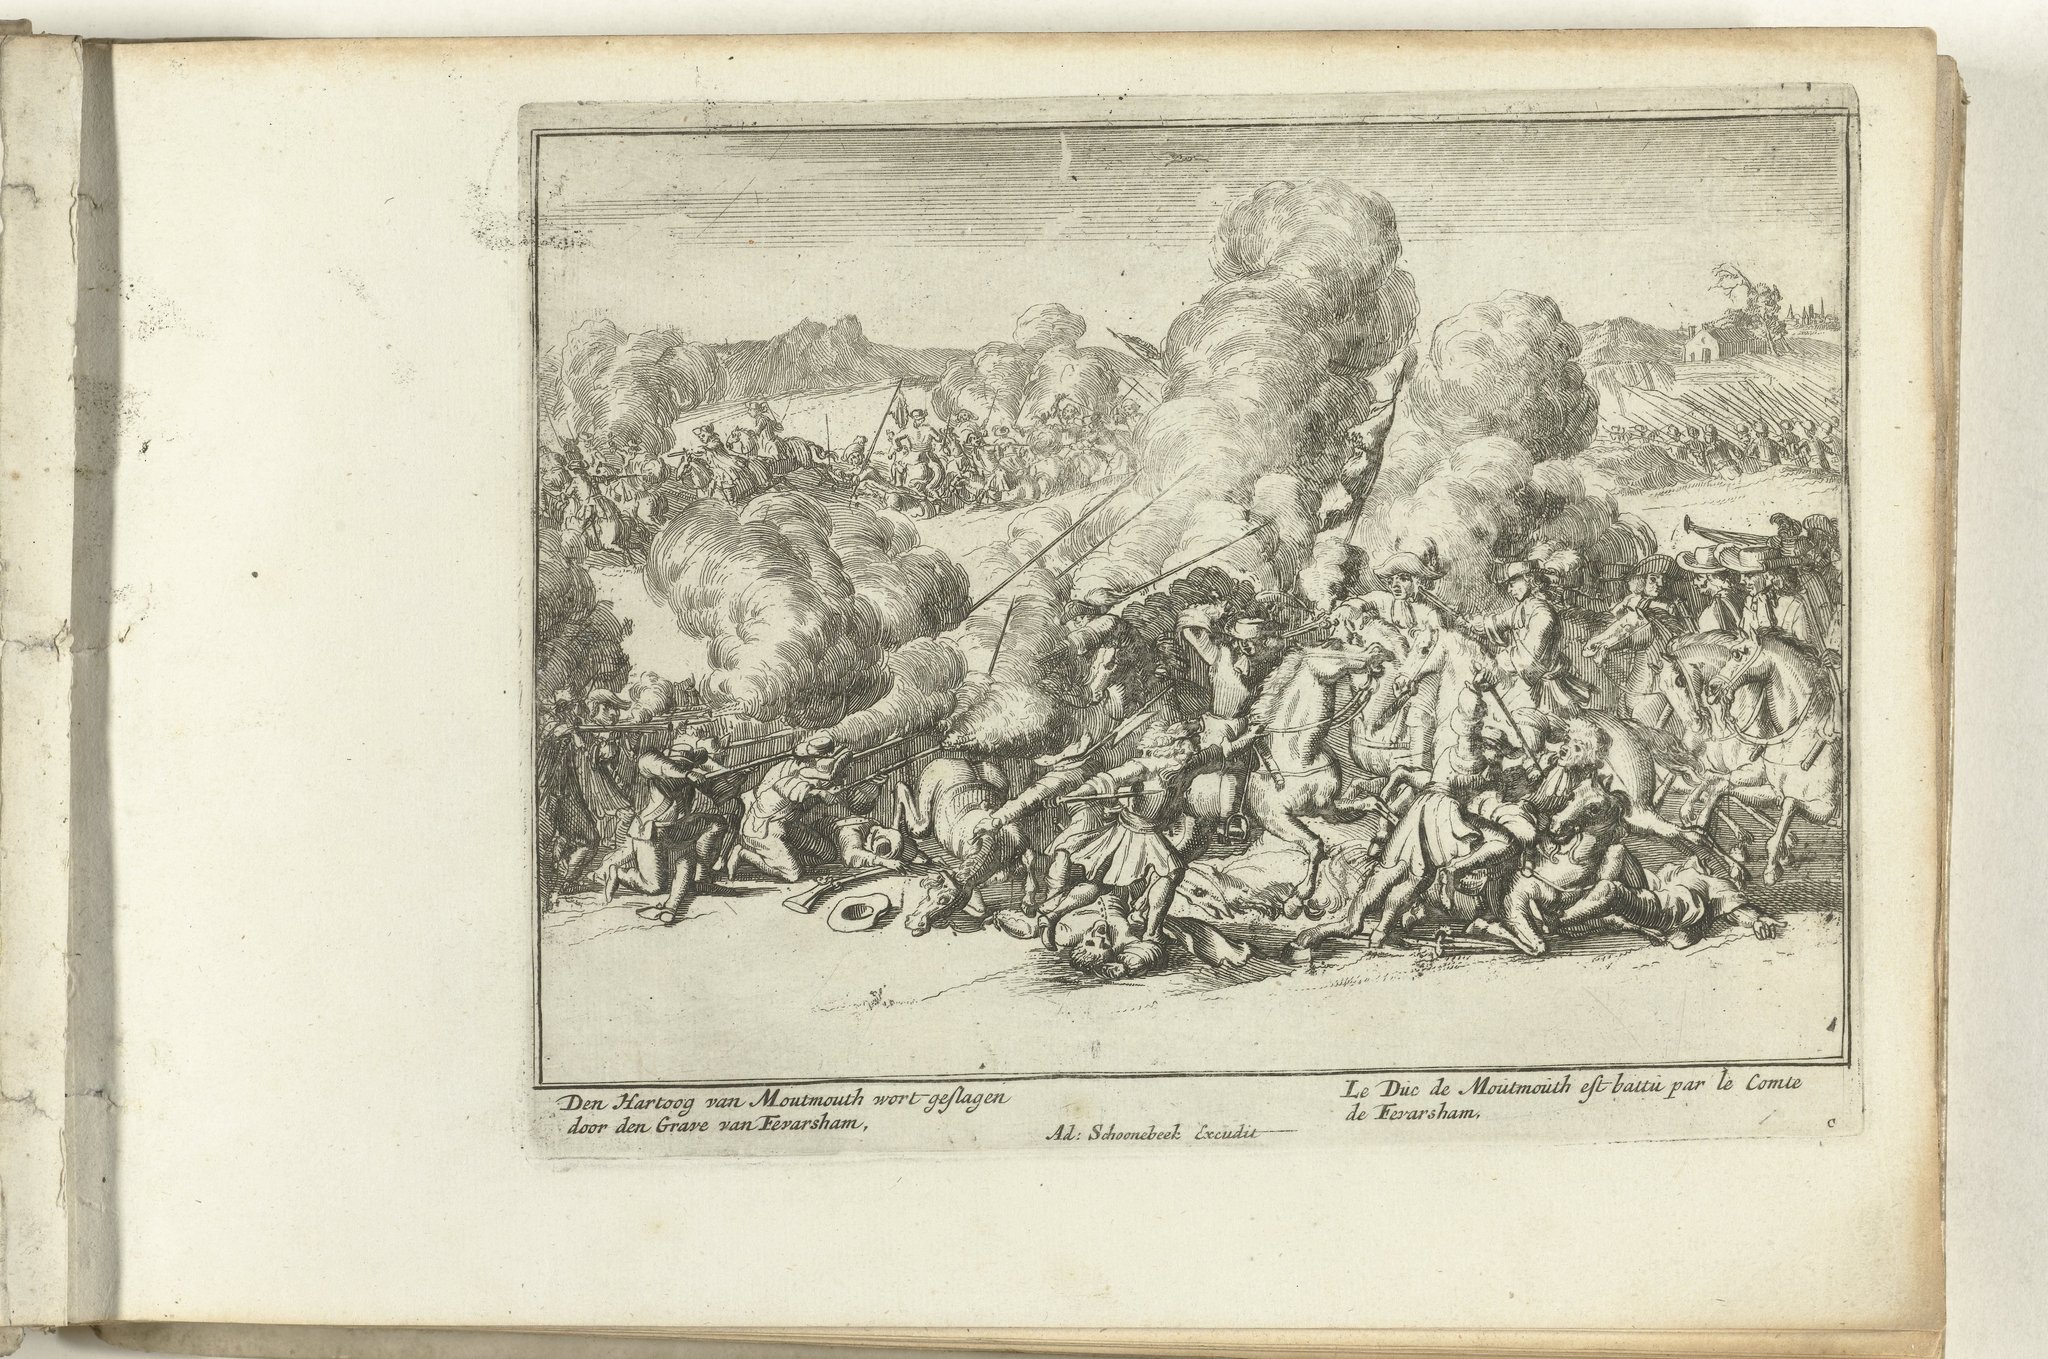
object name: print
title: Monmouth wordt door Feversham verslagen, 1685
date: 1689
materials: paper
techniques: etching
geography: amsterdam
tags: rotterdam, london, battle (+ land forces)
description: De hertog van Monmouth wordt in een veldslag bij Sedgemoor door Feversham verslagen, 6 juli 1685. Plaat C in de serie 'Engelants schouwtoneel' over de Glorious Revolution en gebeurtenissen uit de voorafgaande jaren 1685-1689 (eerste deel). Met onderschriften in het Nederlands en Frans.